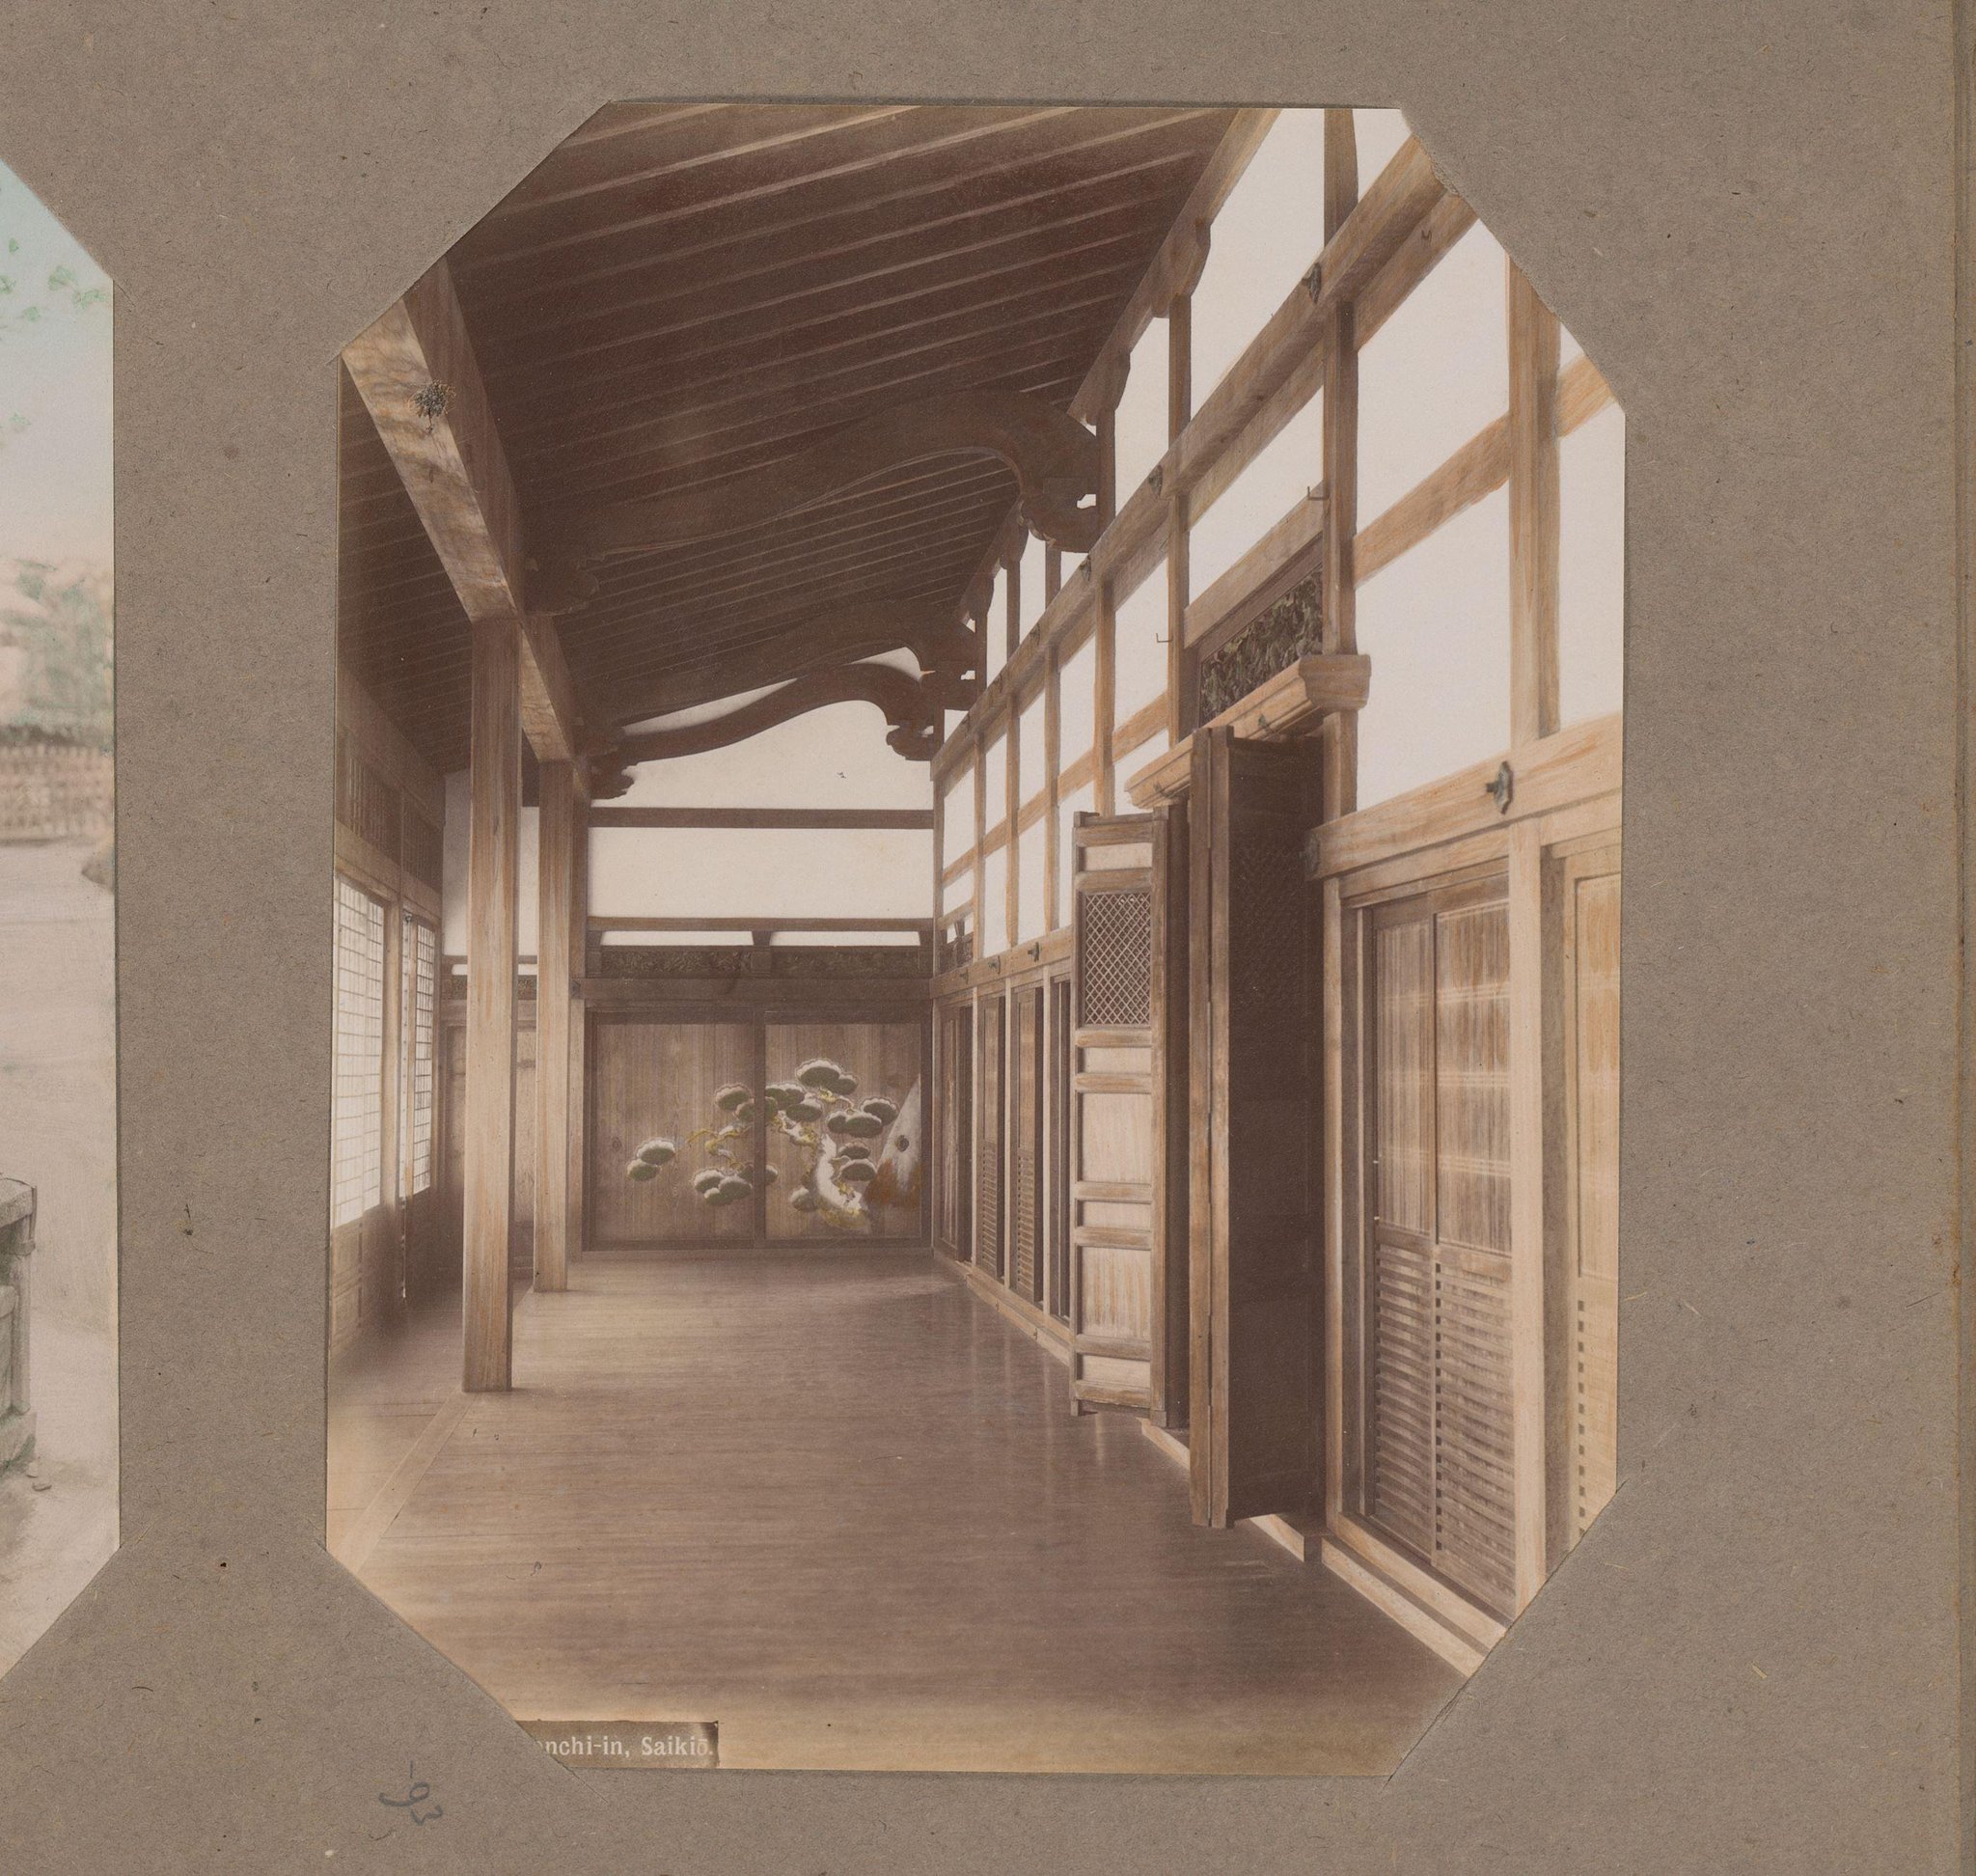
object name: photograph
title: Interieur van de Konchi-in tempel in Sakyo, Kyoto, Japan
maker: Anonymous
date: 1890-1903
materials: paper, photographic support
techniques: albumen print, hand coloring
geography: kyoto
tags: temple, shrine ~ hinduism, buddhism, jainism, interior of the house, kyoto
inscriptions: inscription: ‘1139 Interior of Konchi-in, Saikio’